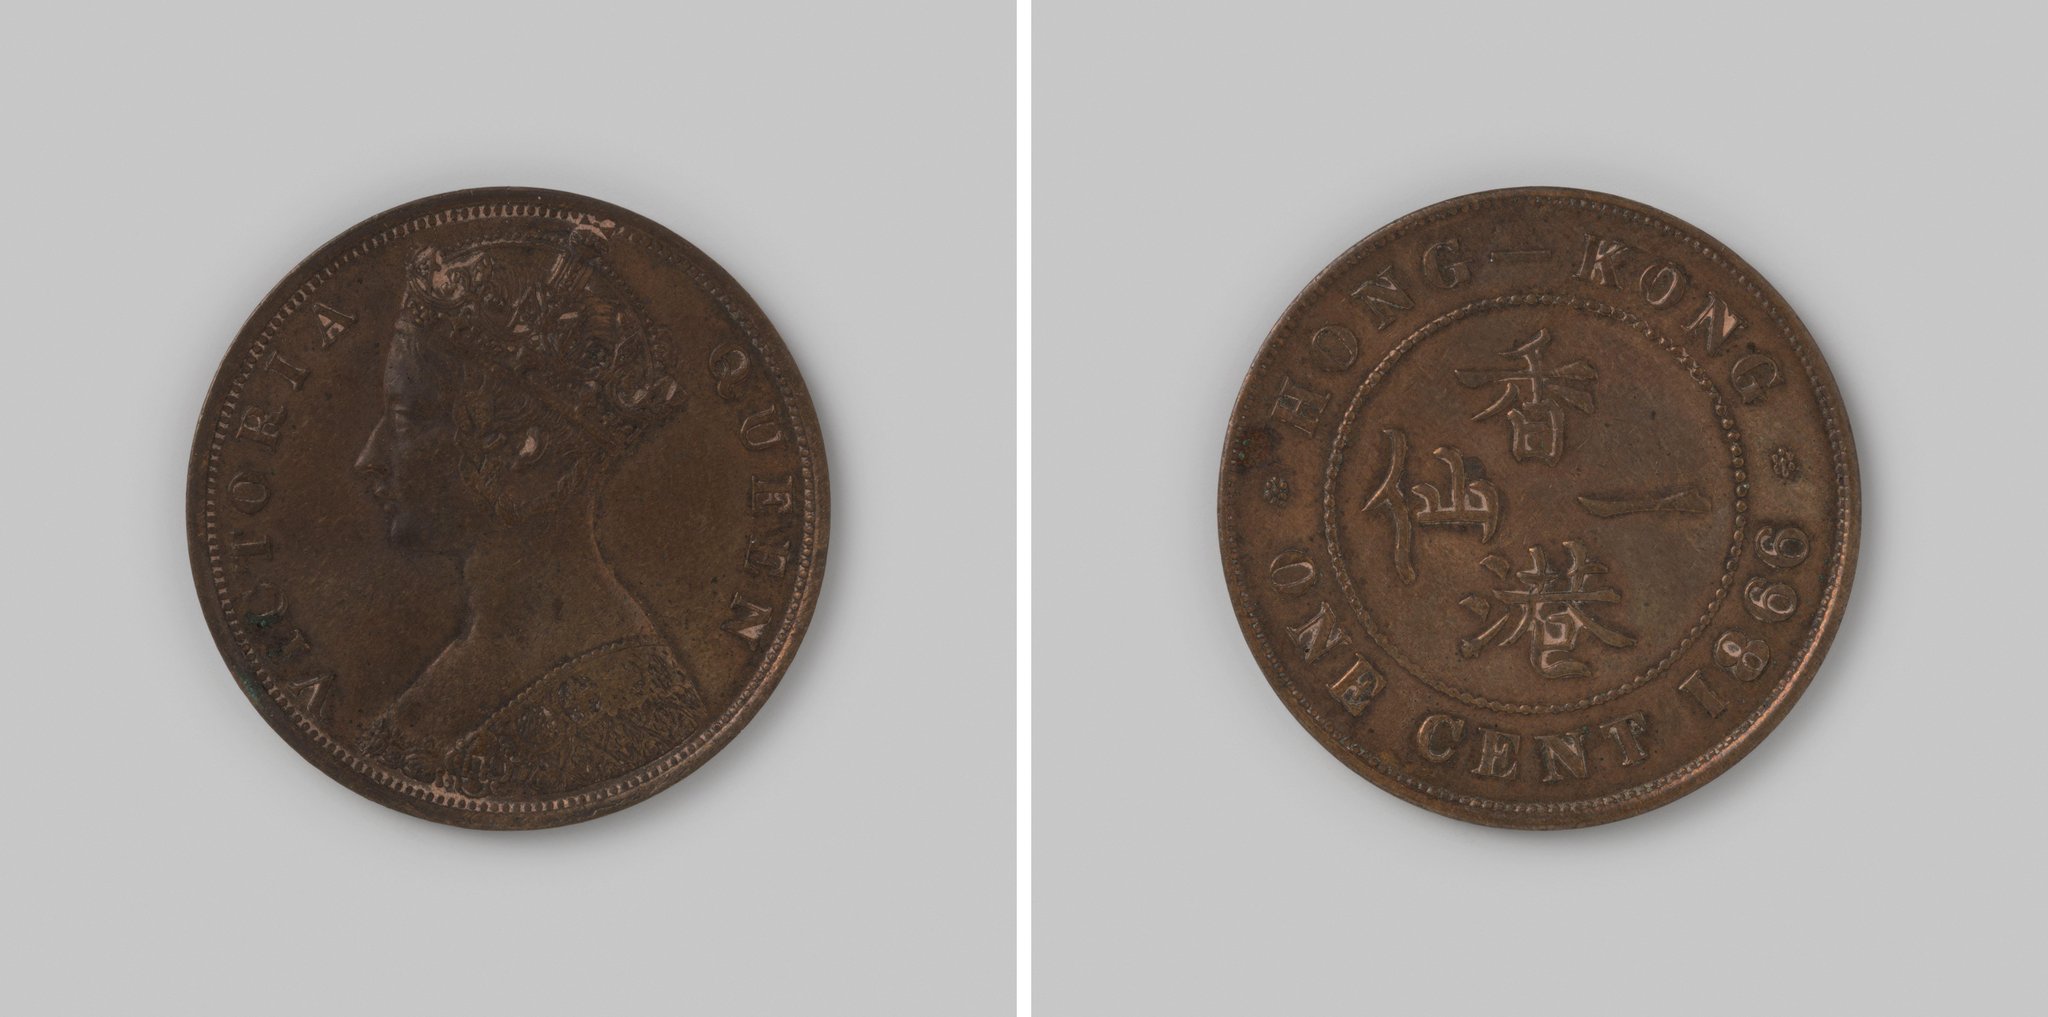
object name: coin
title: Hongkong, koningin Victoria, cent, 1866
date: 1866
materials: bronze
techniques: striking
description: Bronzen munt. Voorzijde: gekroond borstbeeld van de koningin naar links. Keerzijde: in het omschrift waarde-aanduiding: one cent met rechts daarvan jaartal. Gladde rand.